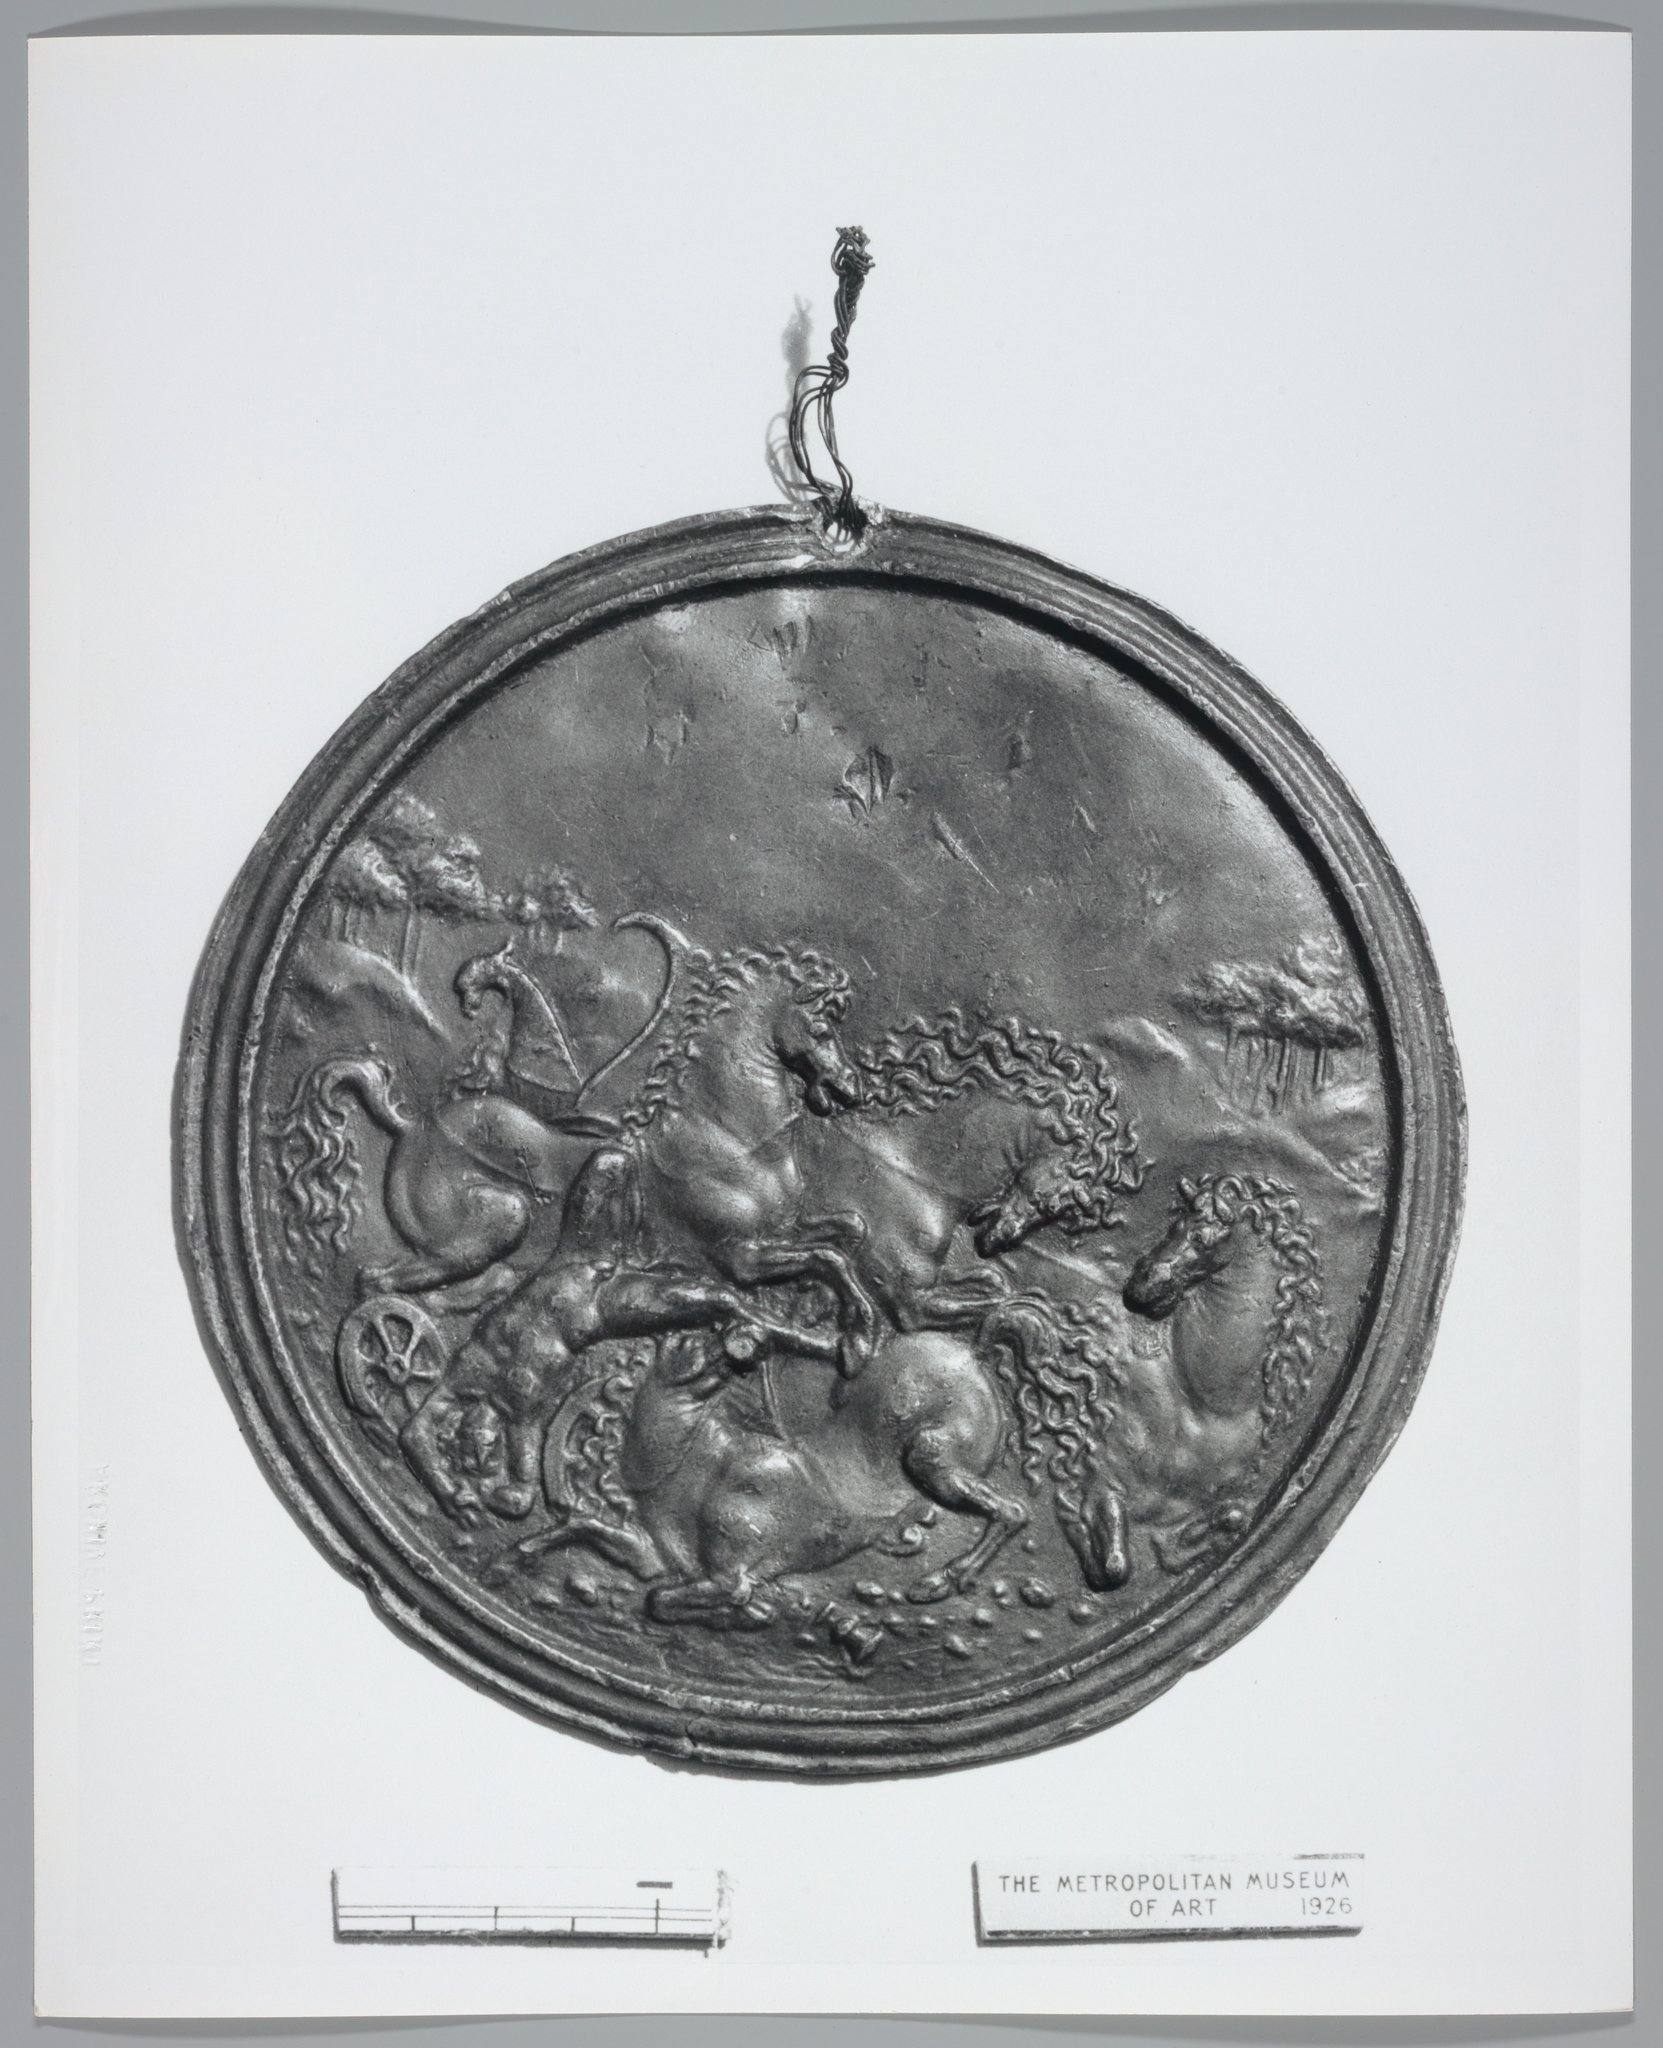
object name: plaquette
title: The Fall of Phaeton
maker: moderno (galeazzo mondella)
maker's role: artist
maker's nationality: italian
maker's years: 1467-1528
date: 1467-1533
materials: lead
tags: horses,trees